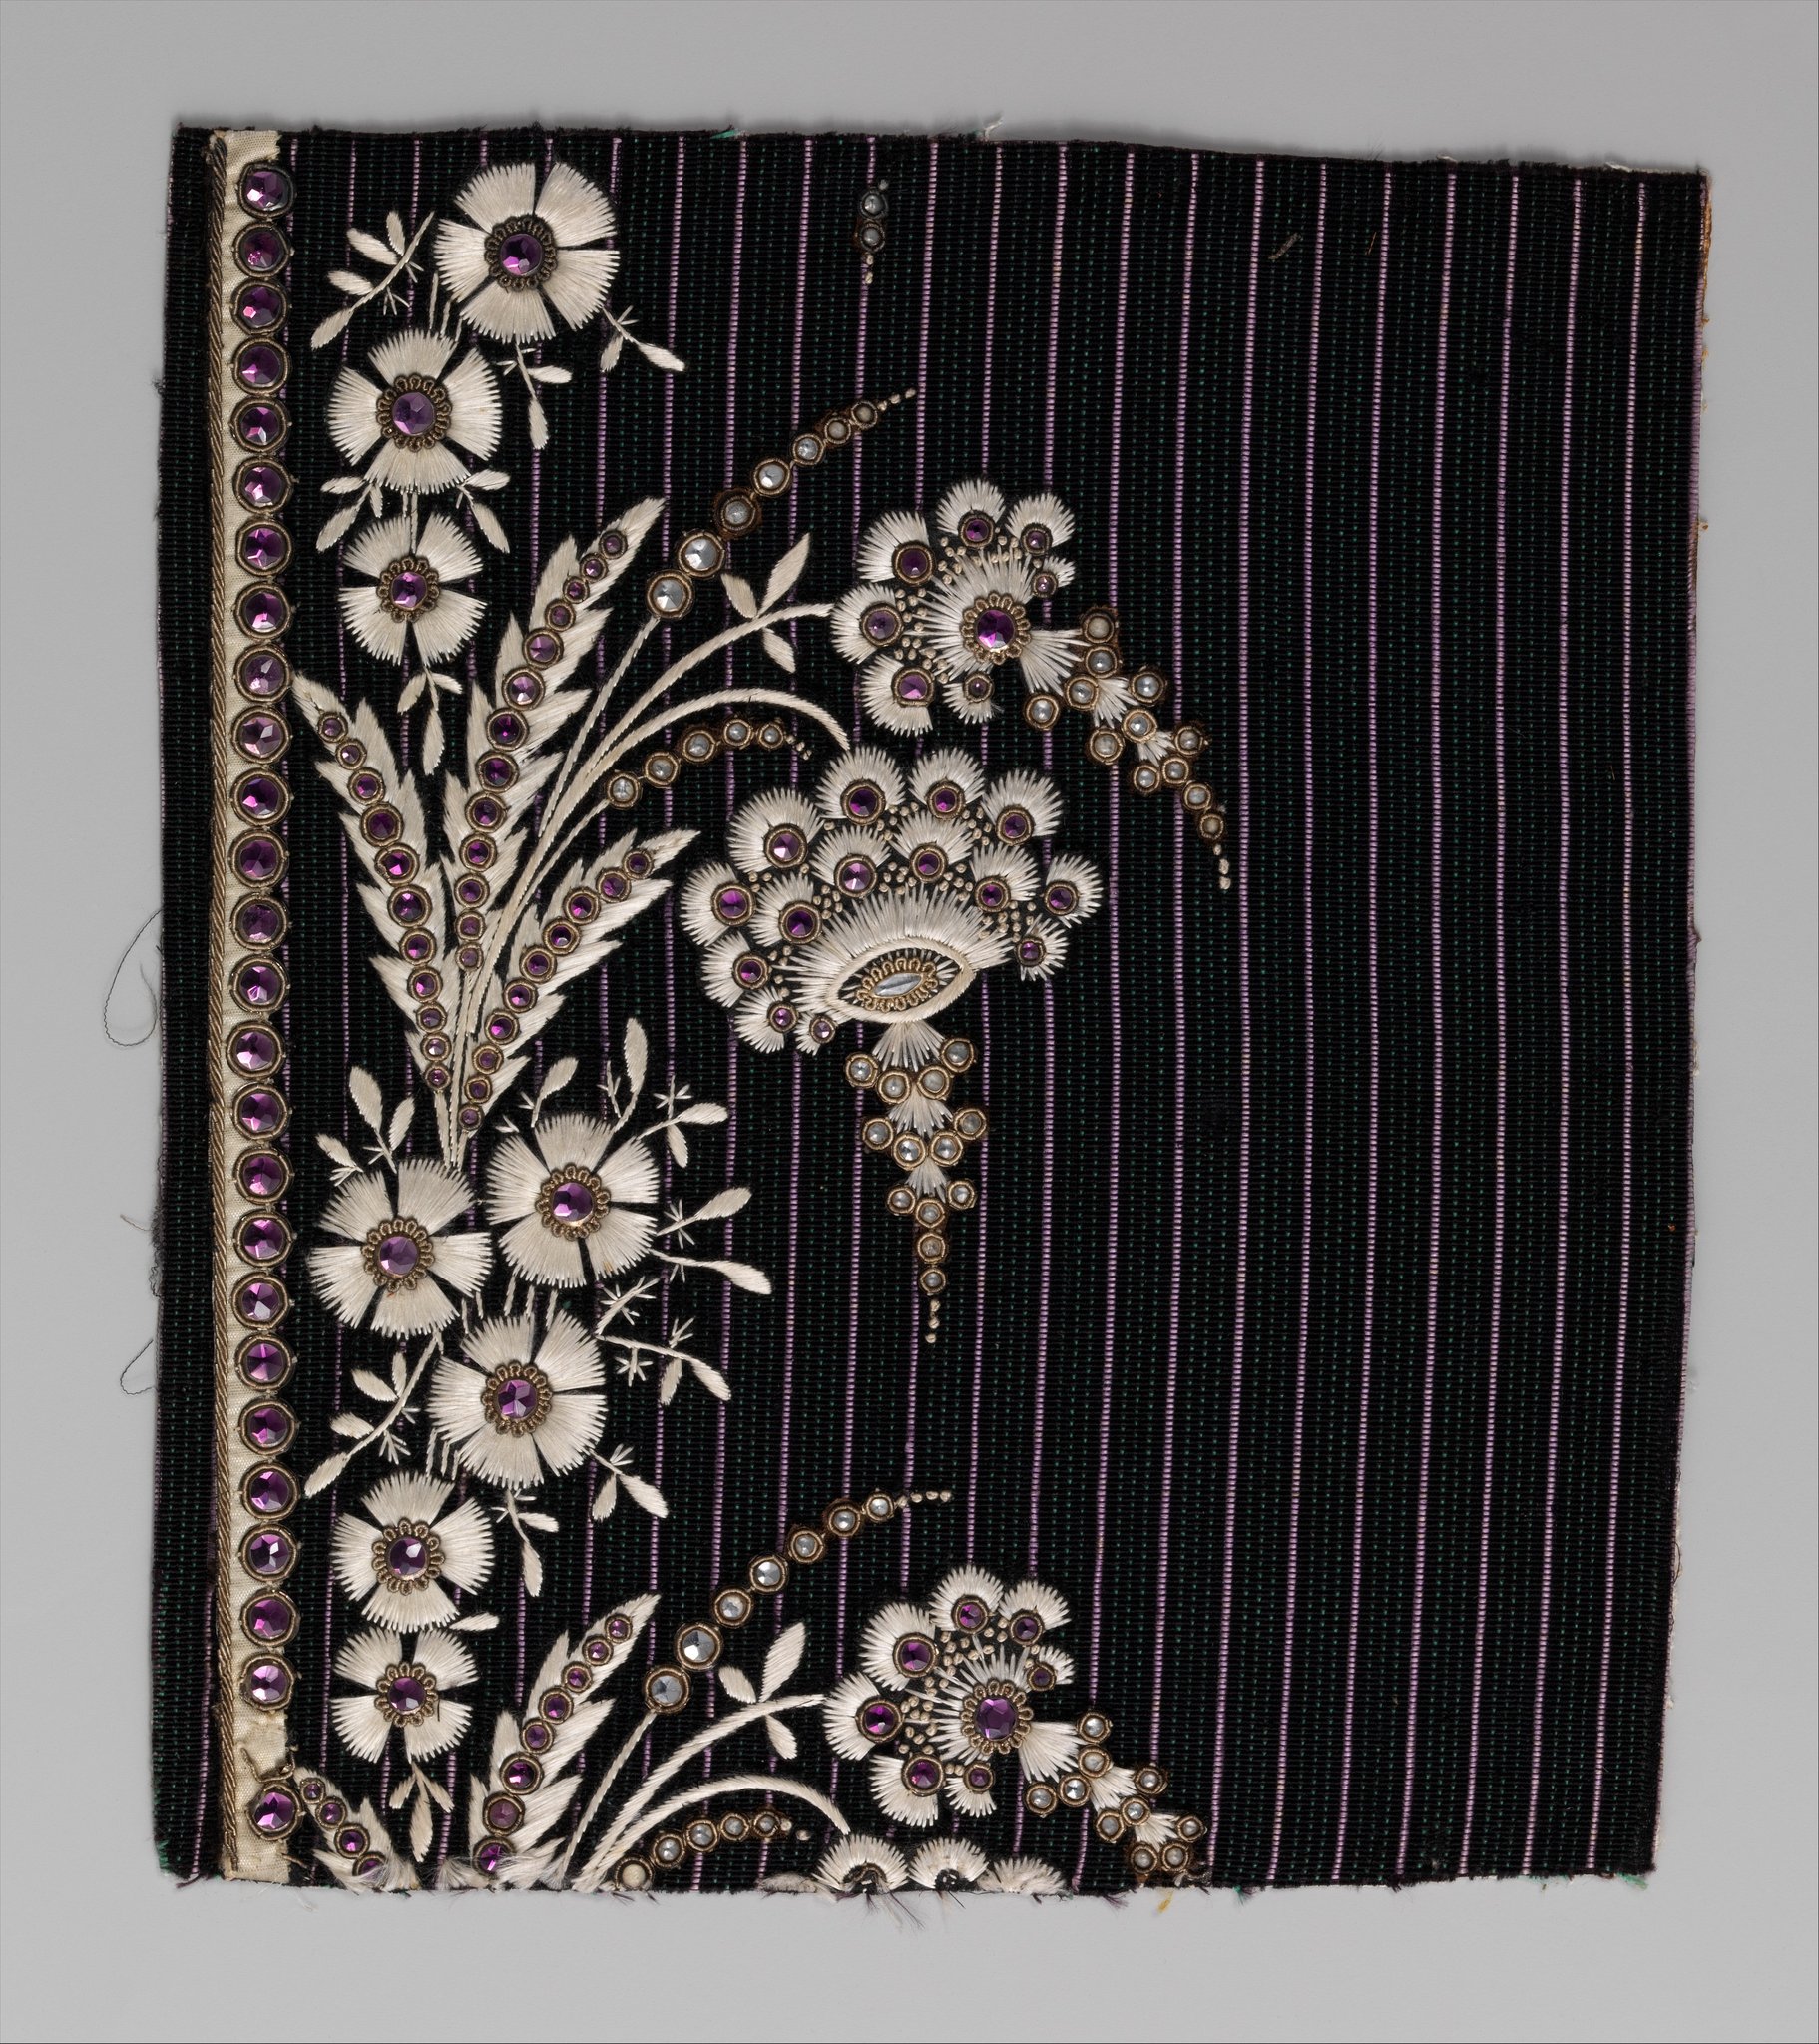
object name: sample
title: Embroidery sample for a man’s suit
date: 1800-1815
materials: glass, metal thread, silk, velvet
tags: flowers